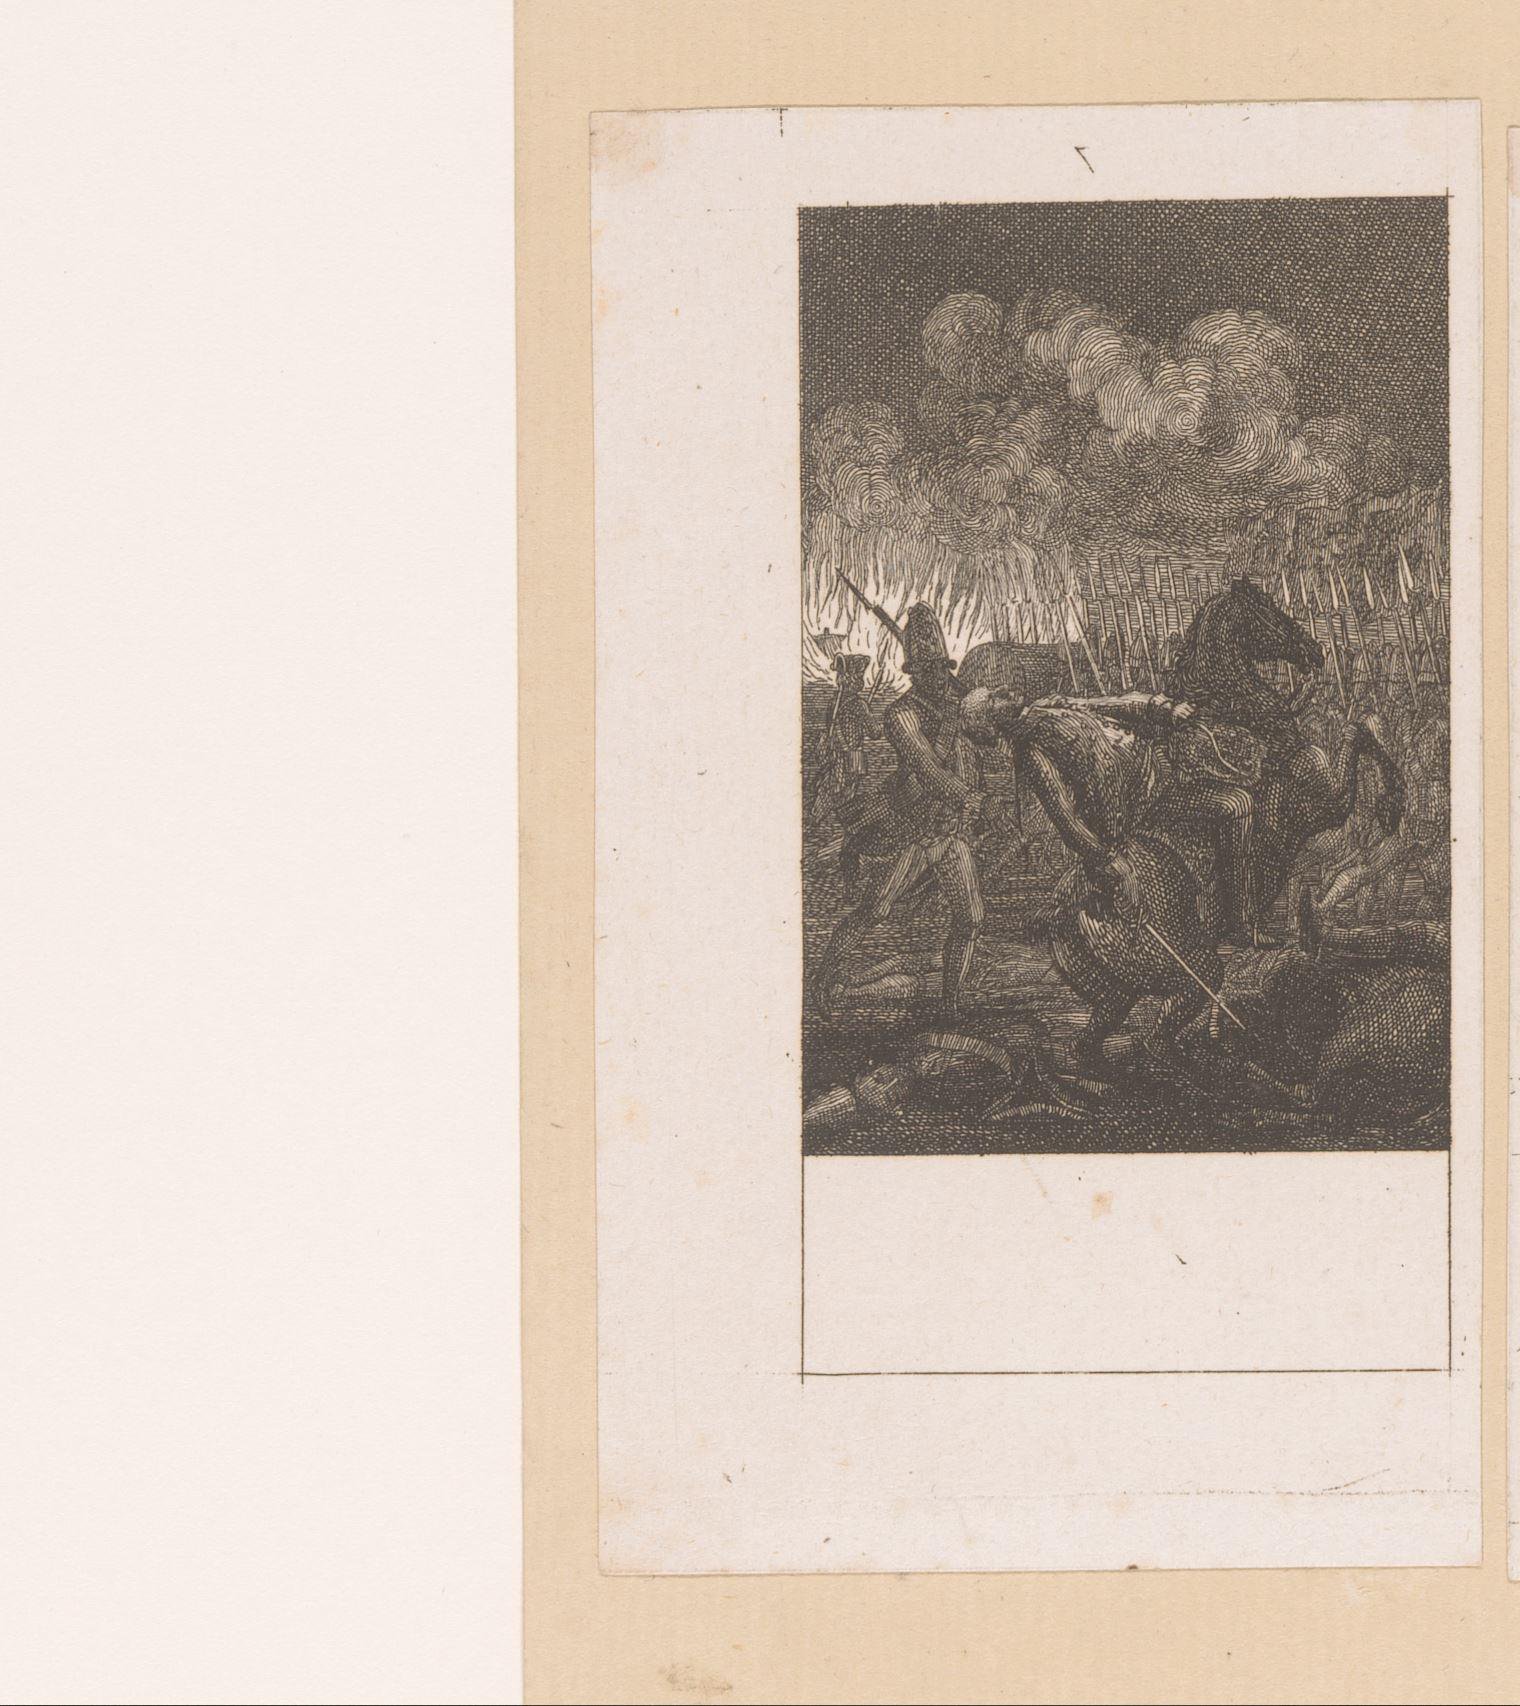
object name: print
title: Steigerend paard met ruiter in een gevecht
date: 1750-1849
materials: paper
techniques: etching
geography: germany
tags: horses and kindred animals, the soldier; the soldier's life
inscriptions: collector's mark: Lugt 2228